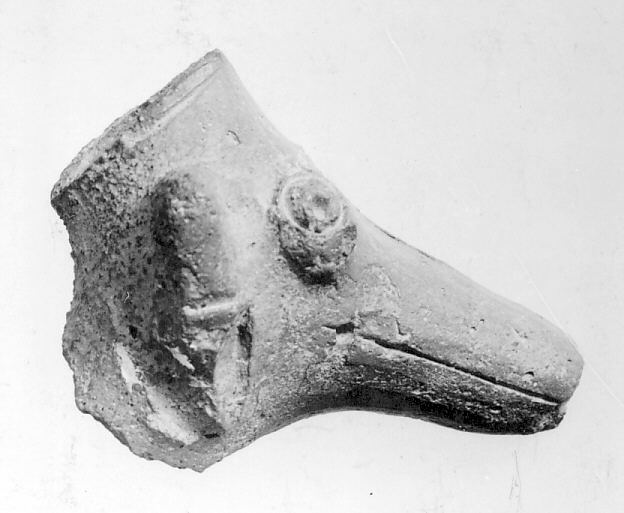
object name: spout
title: Fragment of a Grotesque Head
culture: central asian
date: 1101-1133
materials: terracotta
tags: heads